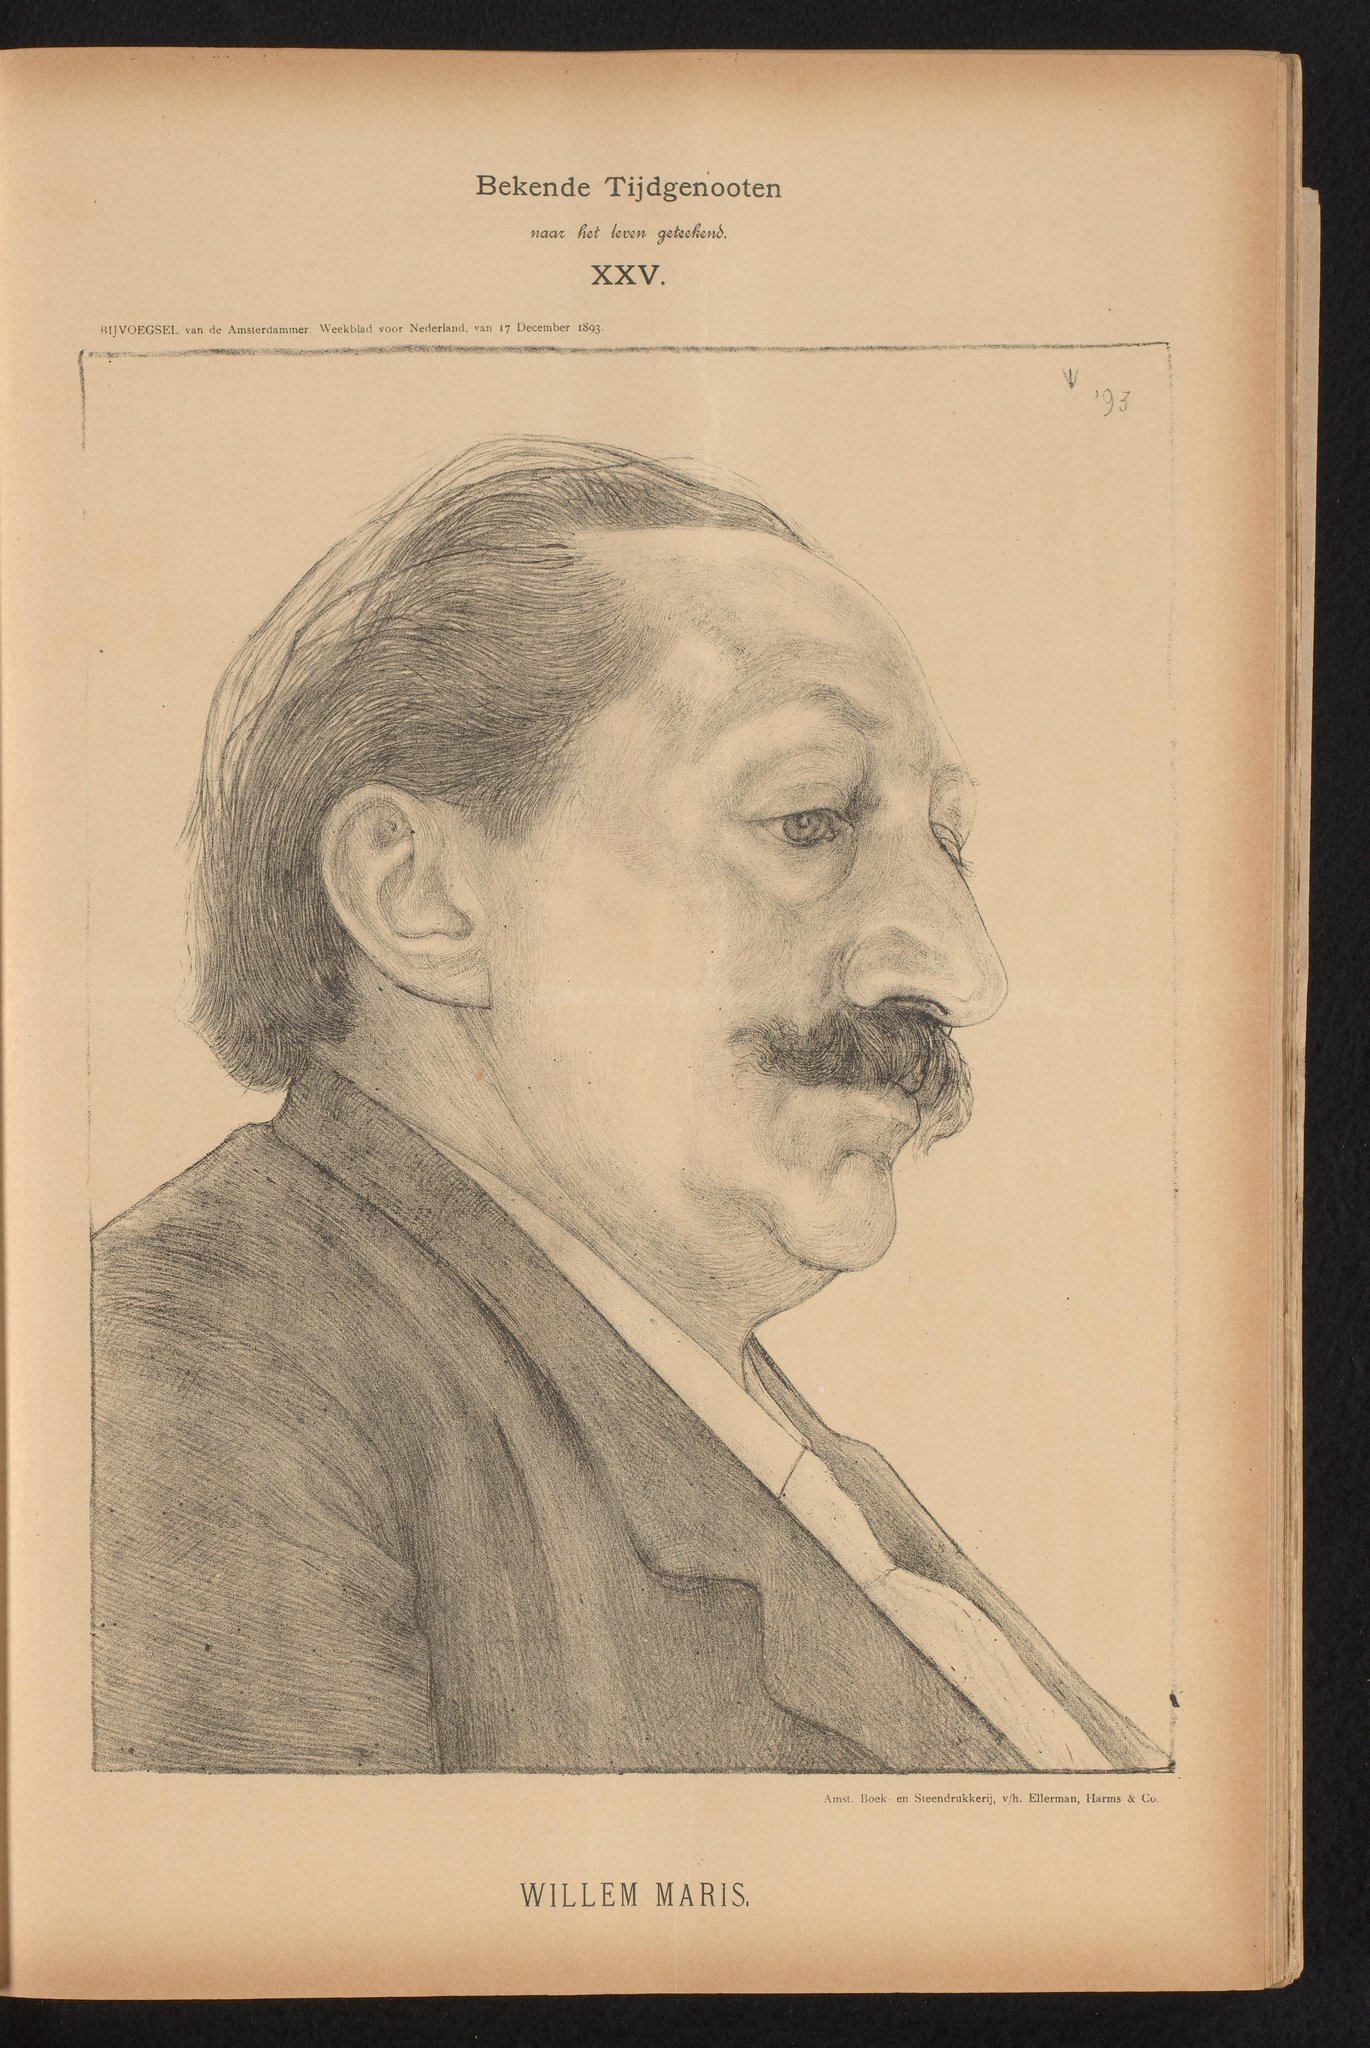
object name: print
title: Willem Maris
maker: jan veth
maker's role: designer, draughtsman, painter, print maker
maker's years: 1864-1925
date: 1893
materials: paper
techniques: lithograph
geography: netherlands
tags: painter, draughtsman, willem maris, historical persons, portrait, self-portrait of painter, portrait, self-portrait of artist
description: Portret van de schilder Willem Maris. In de serie 'Bekende Tijdgenooten', nr. XXV.